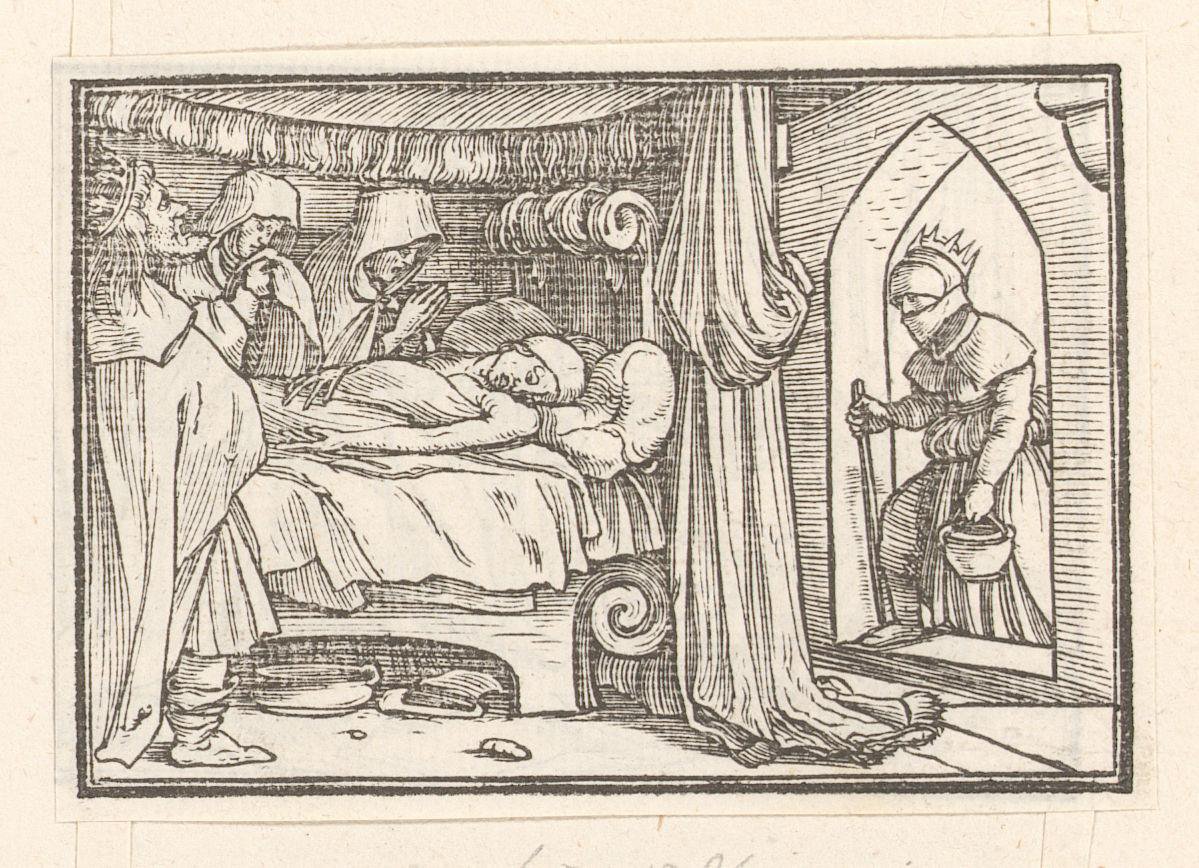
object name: album leaf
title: Geschiedenis van het Oude Testament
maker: veit rudolf specklin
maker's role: print maker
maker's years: -1550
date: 1538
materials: paper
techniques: woodcut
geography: switzerland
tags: the death of jeroboam's son abijah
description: Boekillustratie voor het eerst gebruikt in: Biblia Utriusque Testamenti iuxta Vulgatam Translationem, Lyon, M. en G. Trechsel (voor Hugo à Porta) 1538. Later in verschillende uitgaven opnieuw gebruikt. Deze prent vermoedelijk gebruikt in één van de uitgaven uitgegeven en/of gedrukt door Jean Frellon, Lyon.